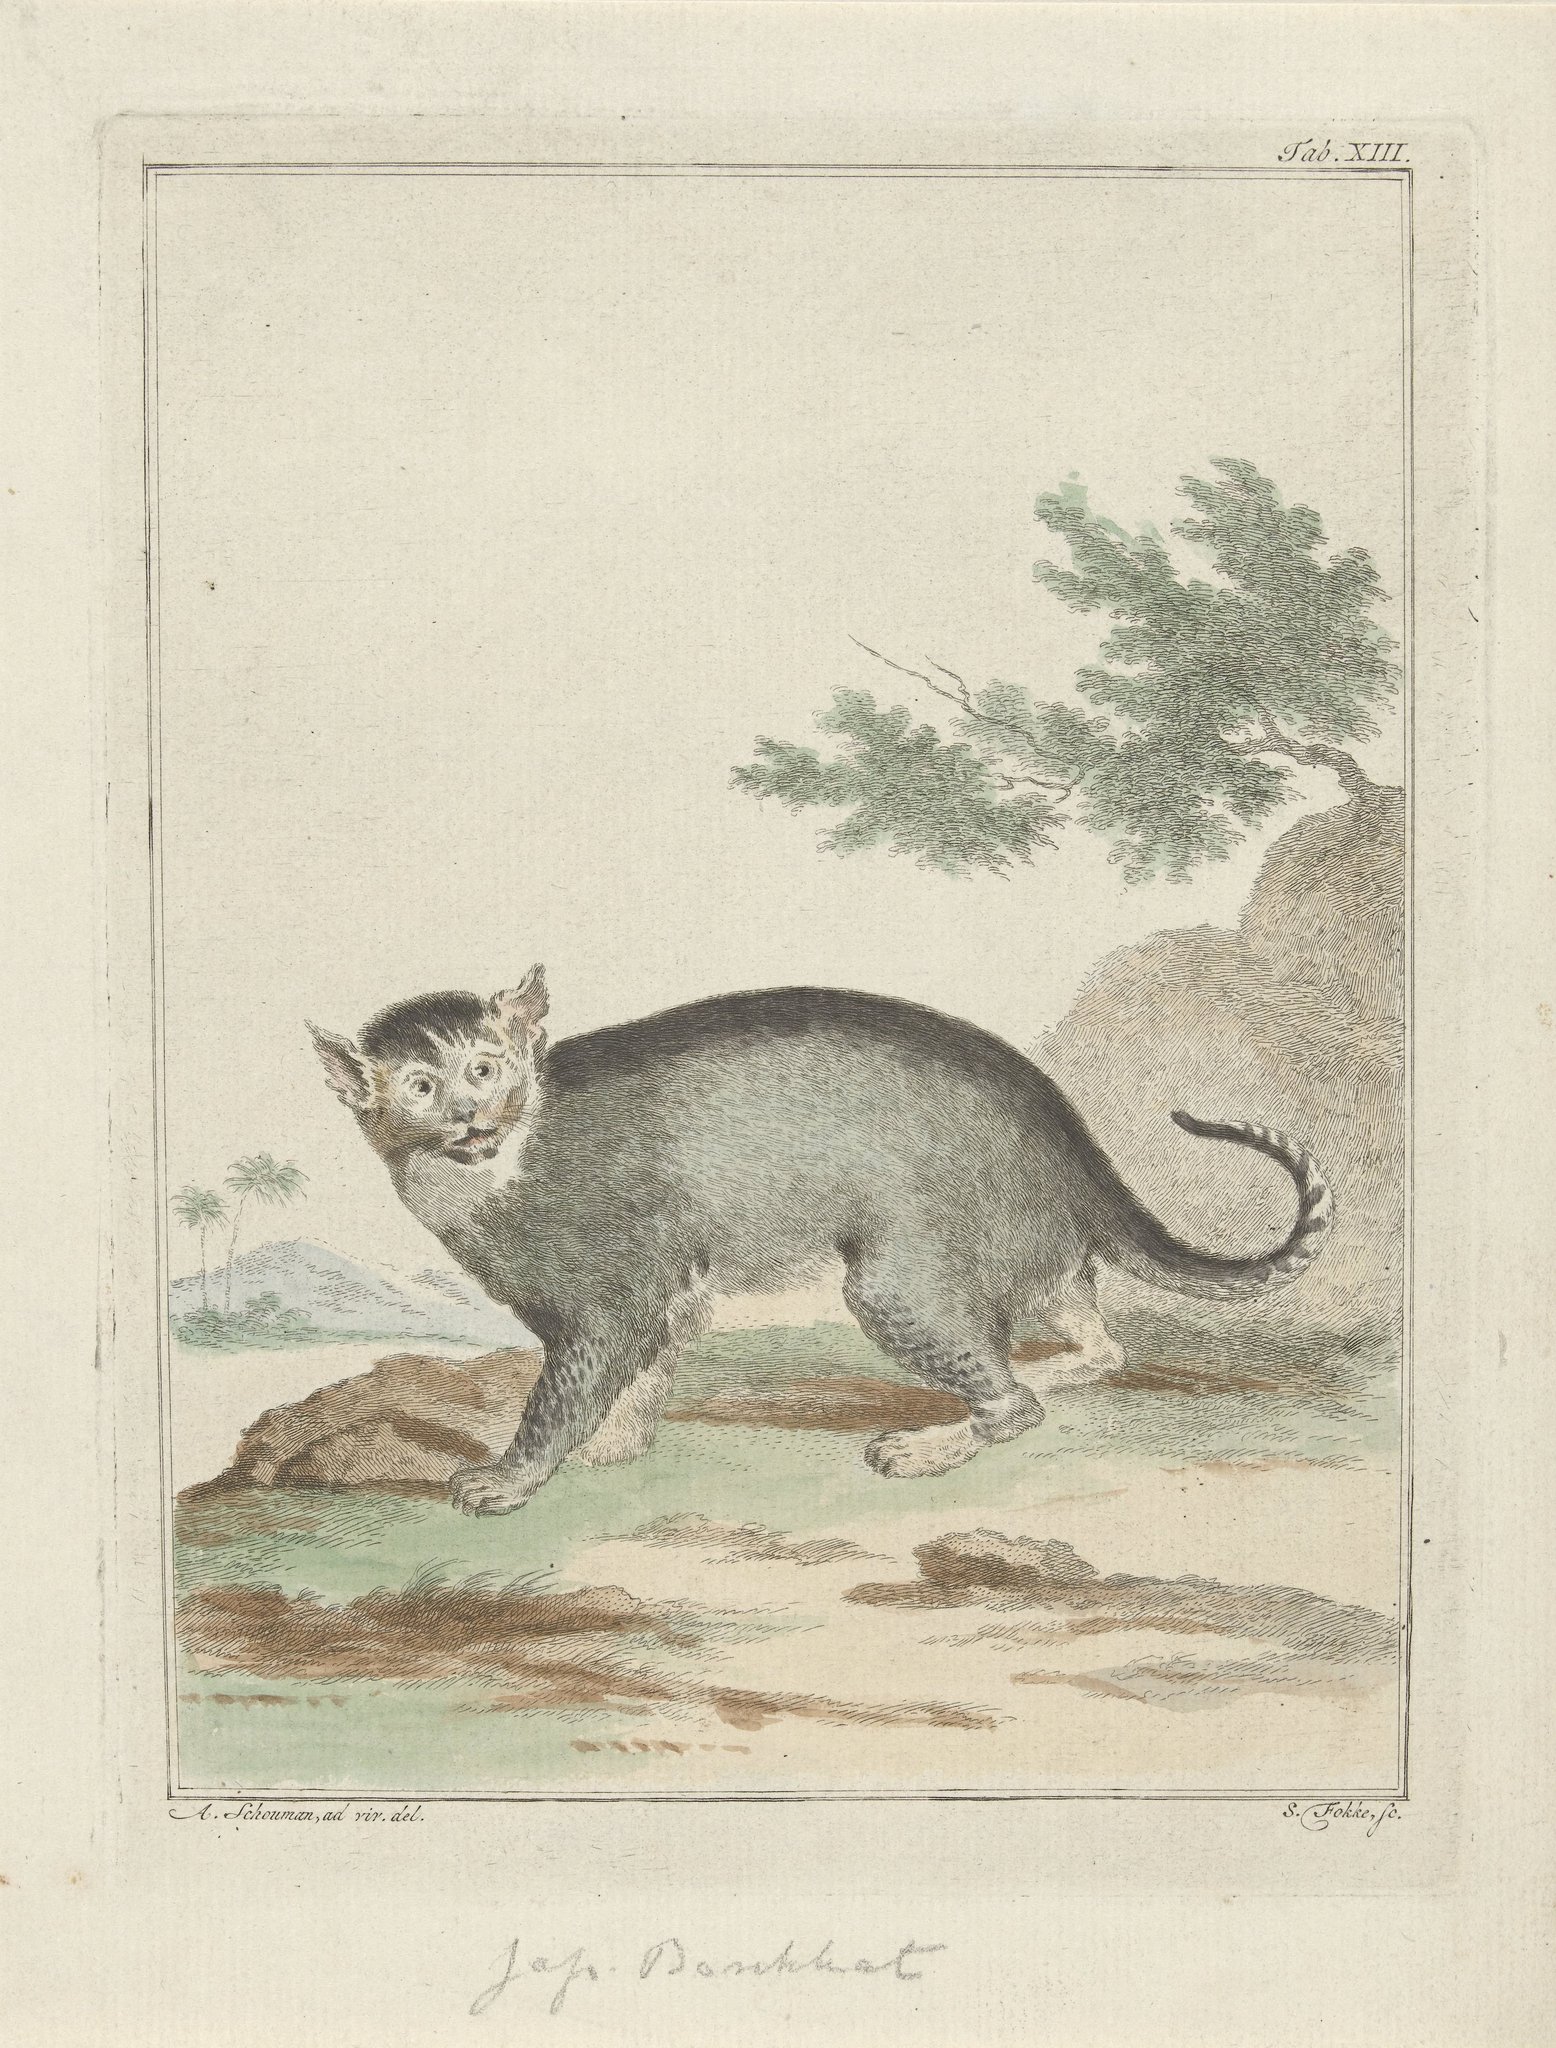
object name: print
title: Japanse Boskat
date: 1722-1784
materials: paper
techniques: etching, hand coloring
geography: amsterdam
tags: animals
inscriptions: collector's mark: Lugt 2228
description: Kopie naar prent in: Vosmaer, Arnouth. Natuurkundige beschryving eener uitmuntende verzameling van zeldsaame gedierten : bestaande in Oost- en Westindische viervoetige dieren, vogelen en slangen : weleer leevend voorhanden geweest zynde, buiten den Haag, op het Kleine Loo van Z.D.H. den Prins van Oranje-Nassau. Amsterdam: J.B. Elwe, 1804.